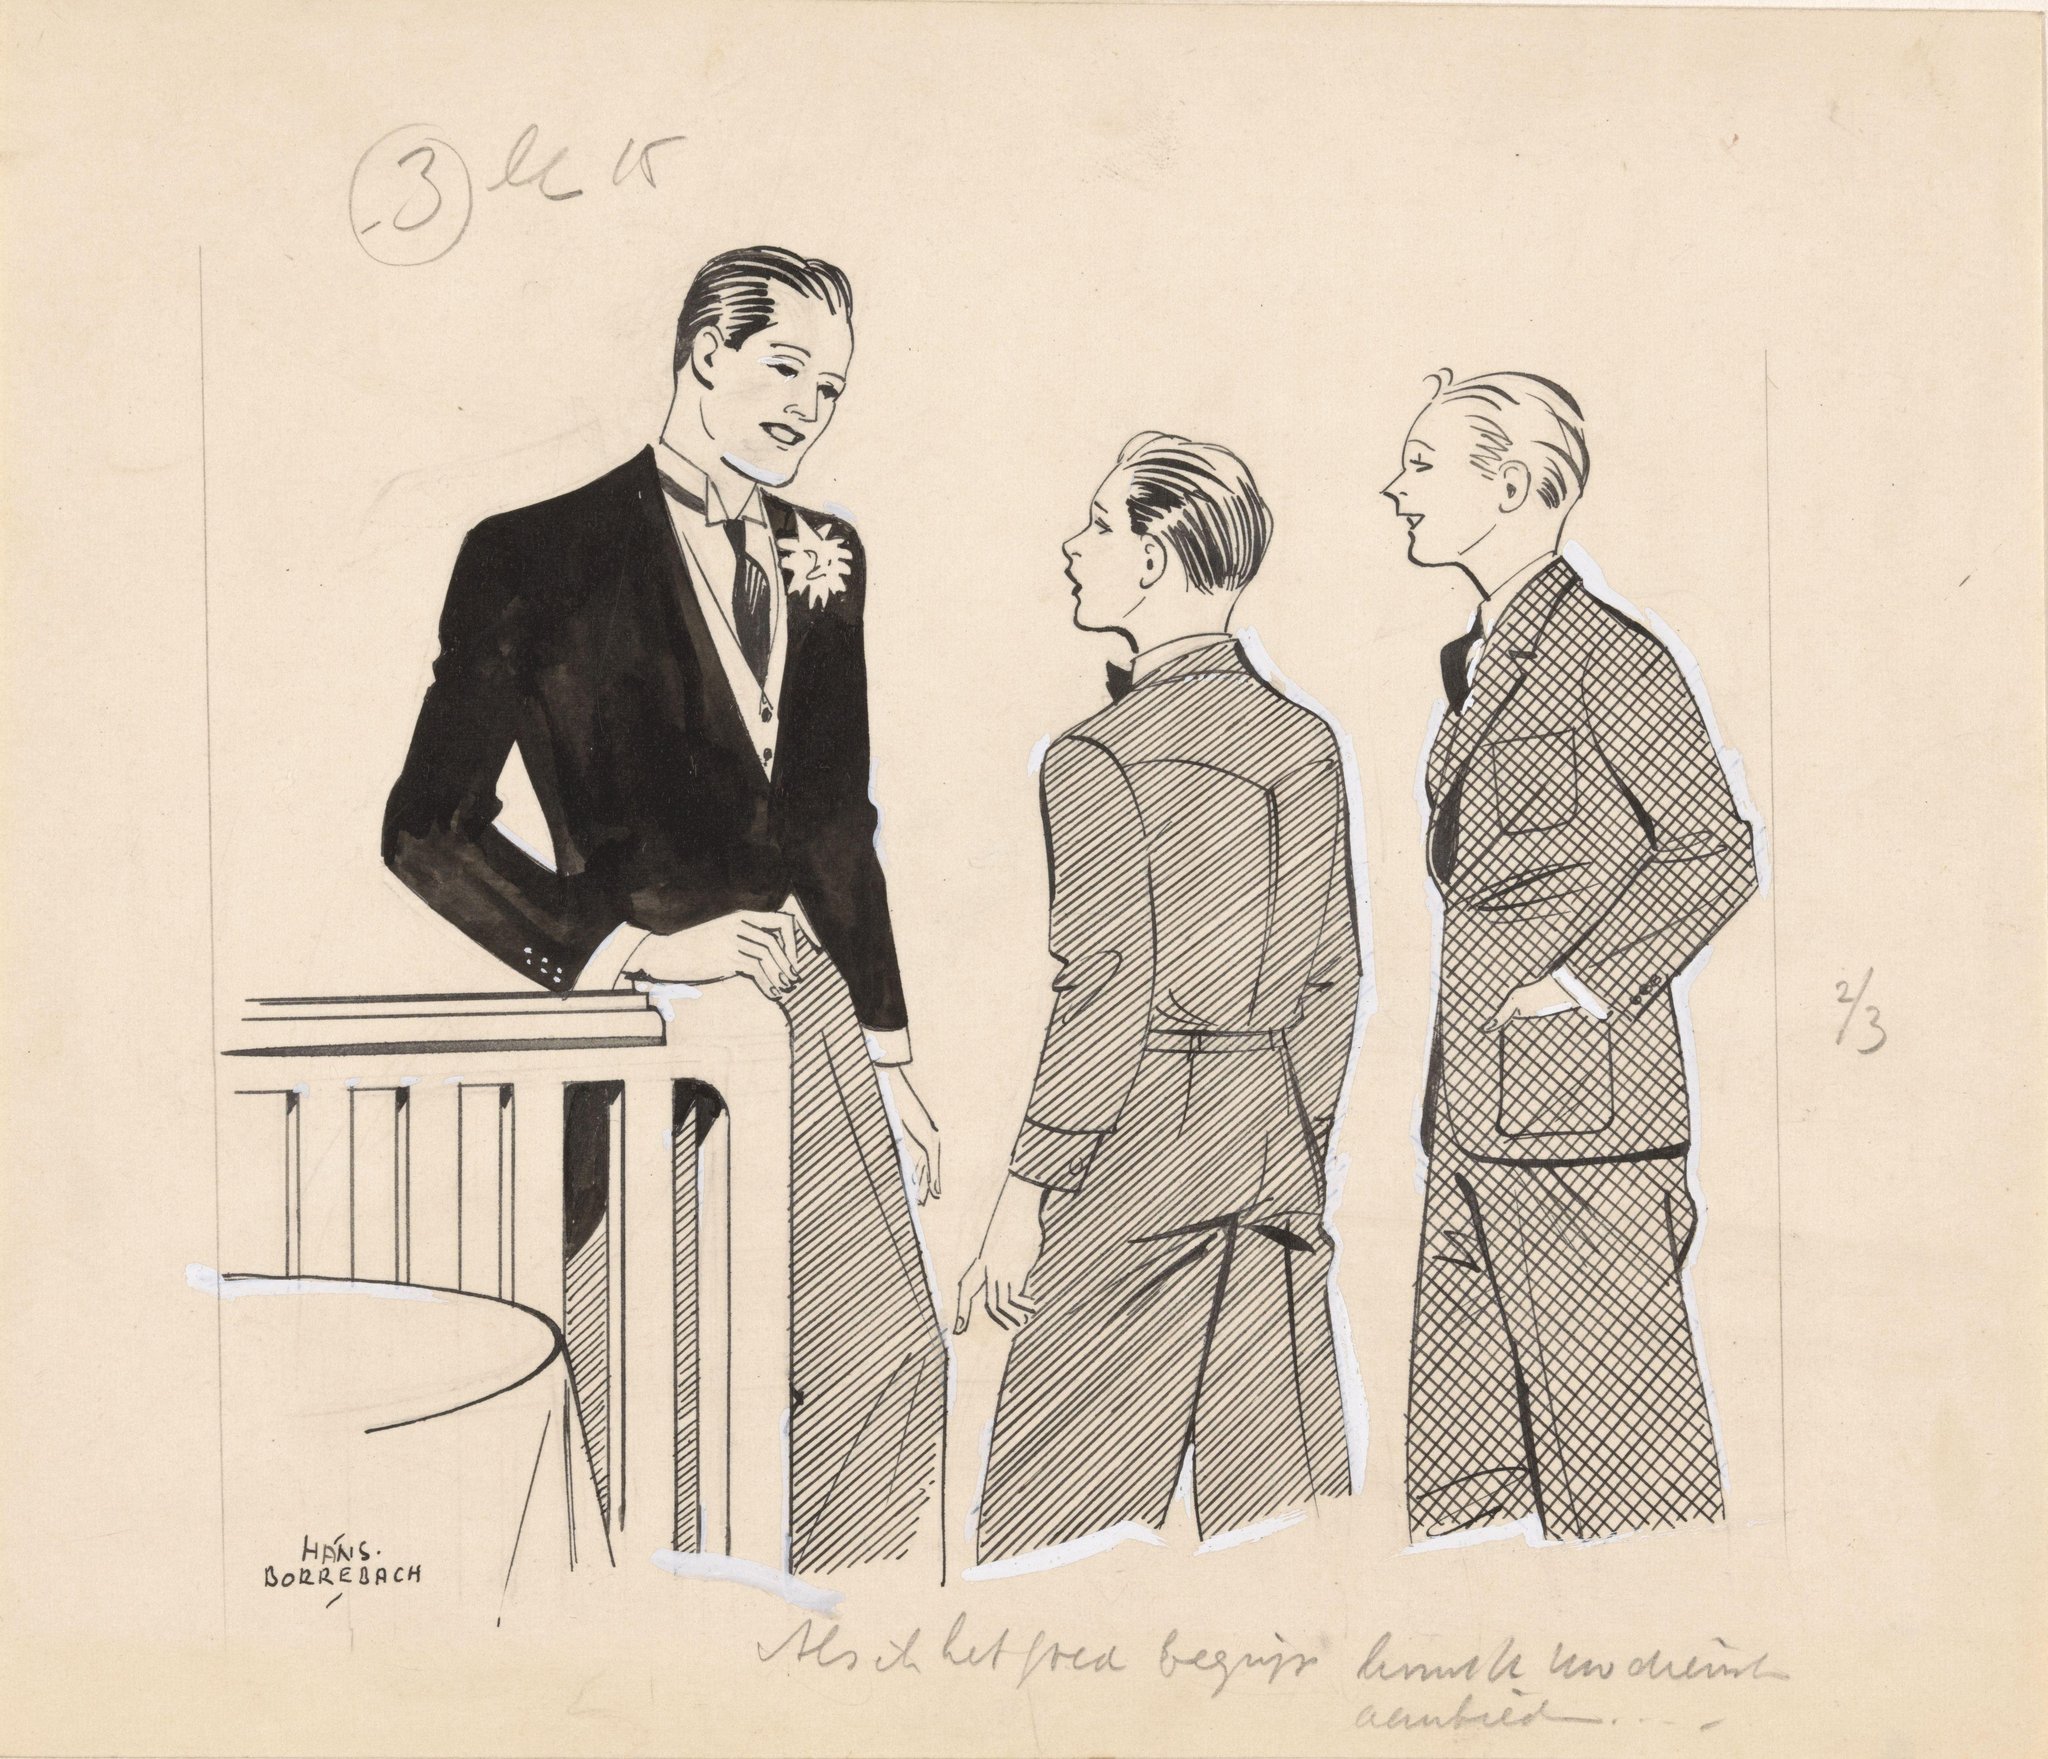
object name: boekillustratie ontwerp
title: Twee jonge mannen spreken met een man in jacquet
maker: hans borrebach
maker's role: draughtsman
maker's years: 1903-1991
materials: paint, ink, paper, pencil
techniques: brush, pen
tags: fence, wall, paling, conversation, dialogue; conversation piece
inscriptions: annotation: ‘3 blz 15/ Als ik het goed begrijp komt u uw diensten/ aanbieden’, signature: ‘HANS./ BORREBACH’, collector's mark: Lugt 2228a, :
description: Een man in jacquet leunt met zijn rechterhand op een laag hek. Hij spreekt met twee jonge mannen die tegenover hem staan.